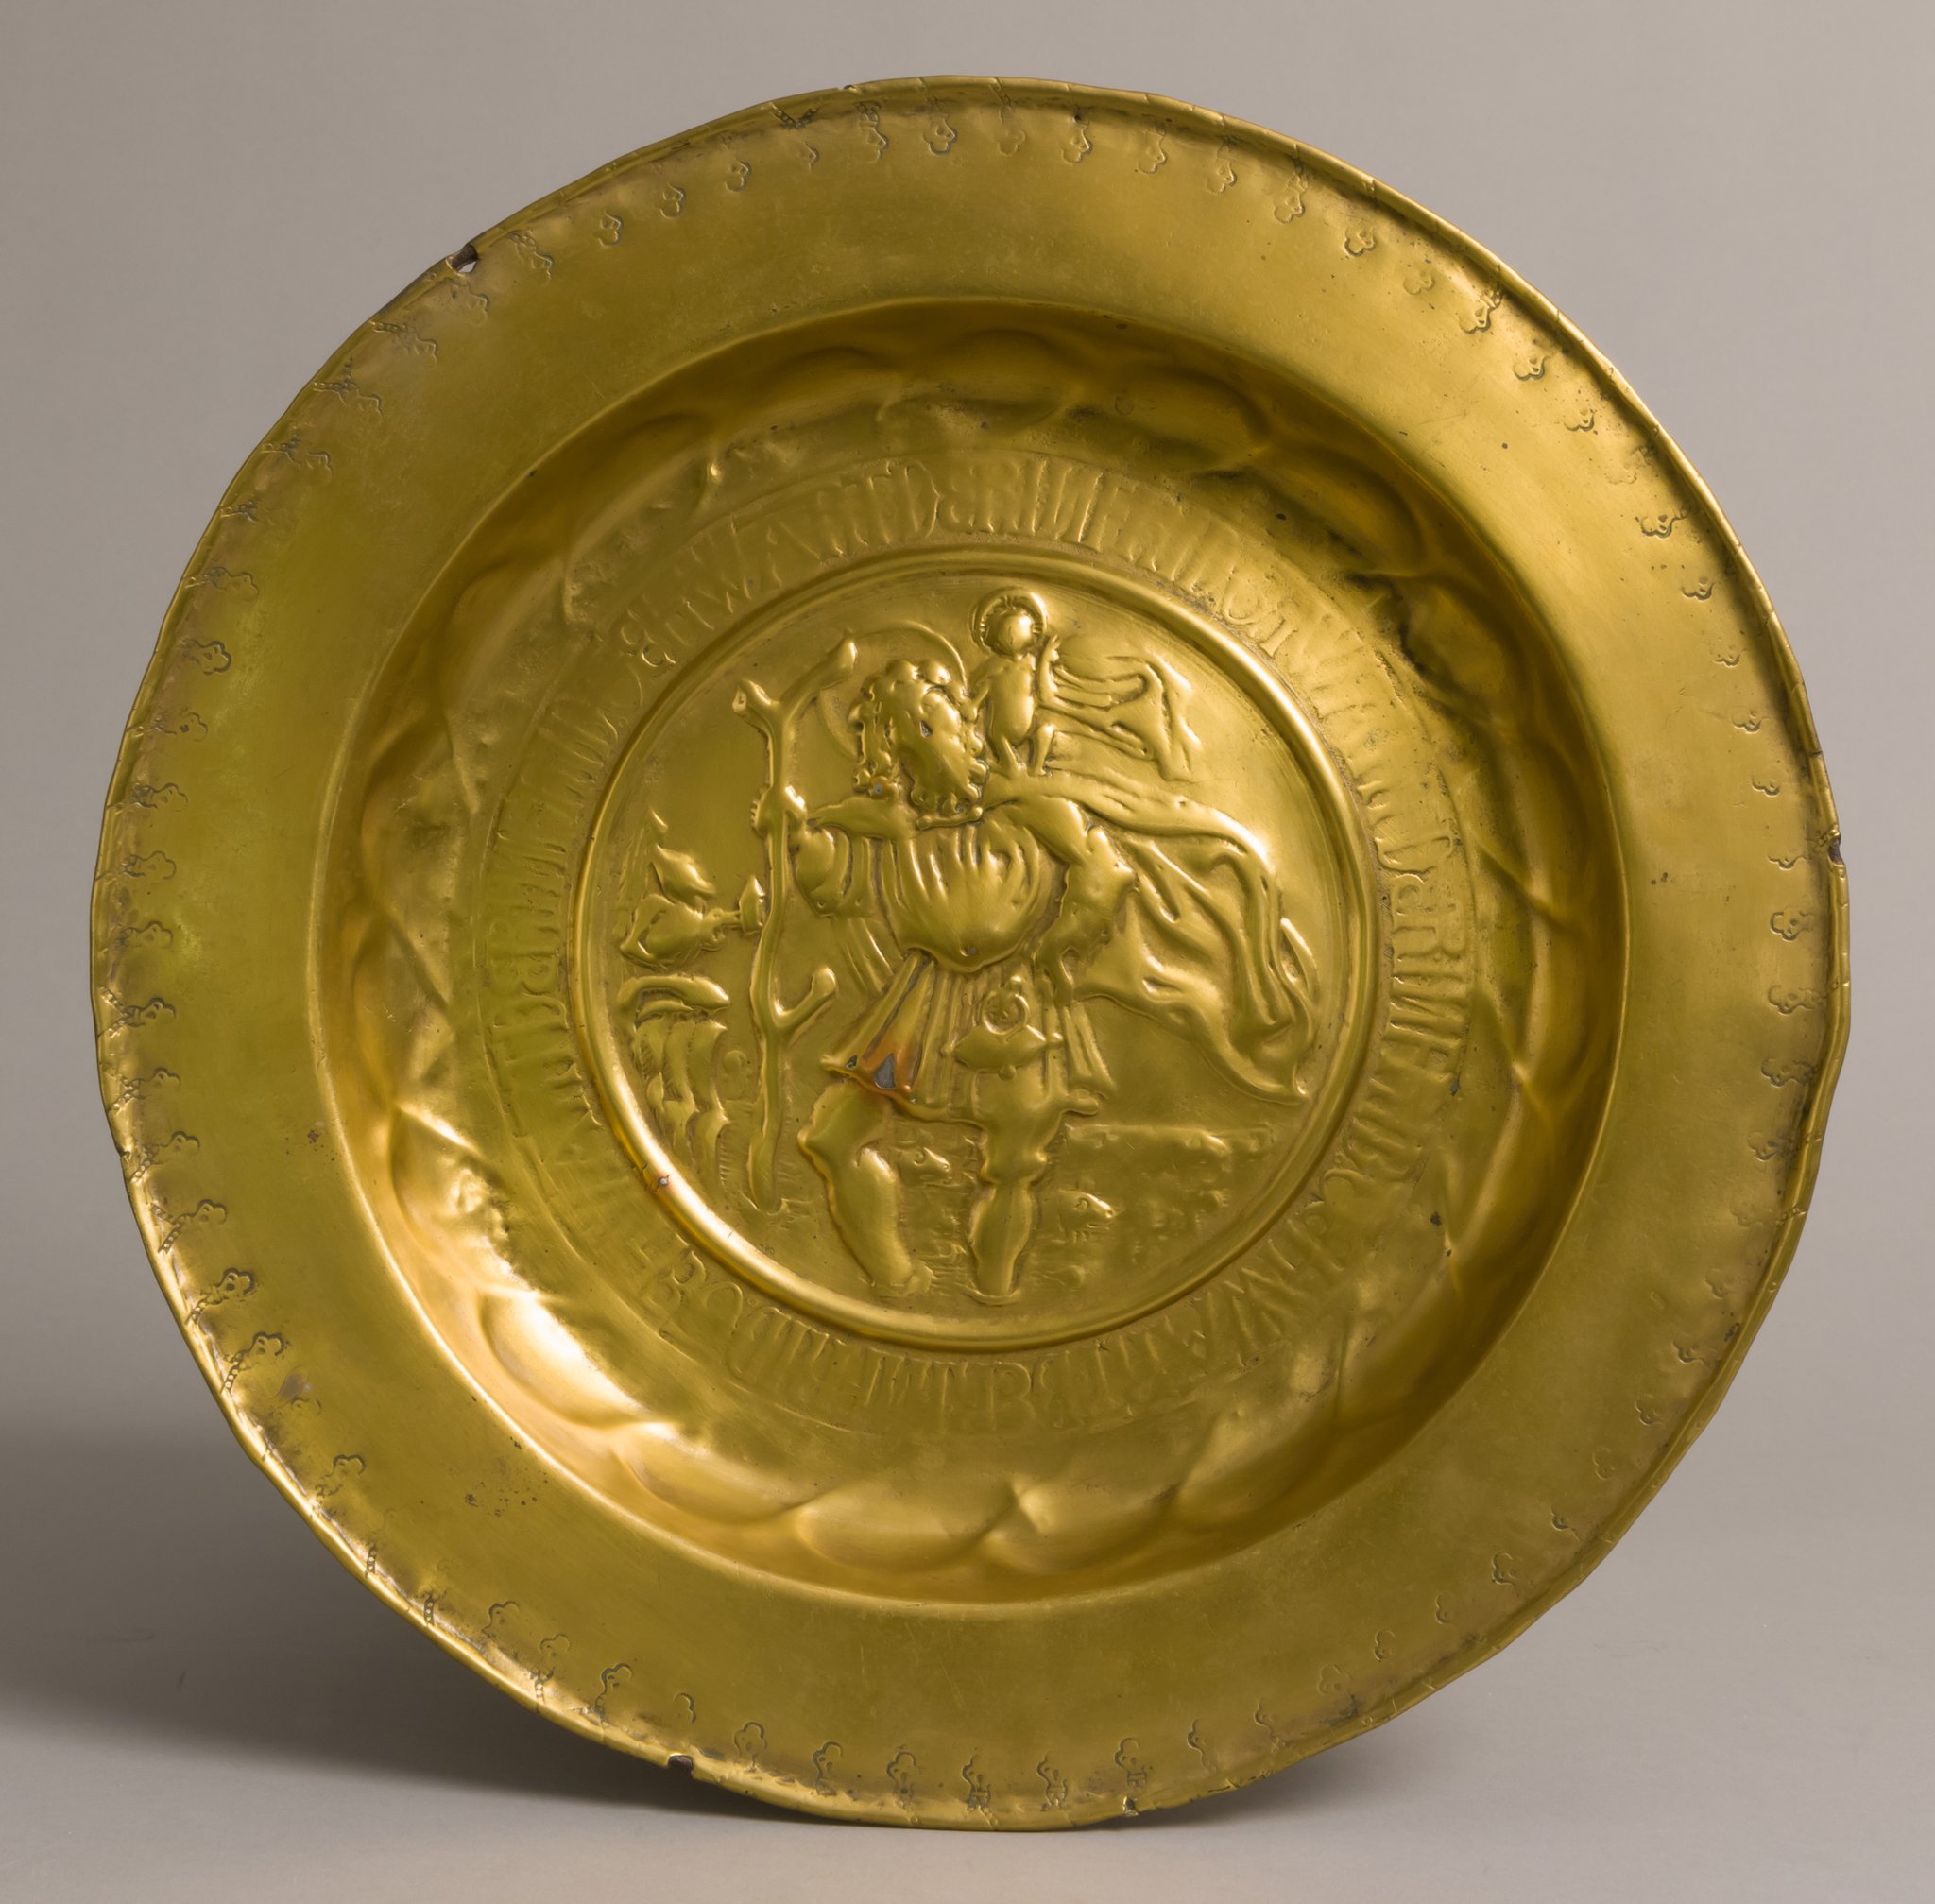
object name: dish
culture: german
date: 1501-1533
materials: brass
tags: men